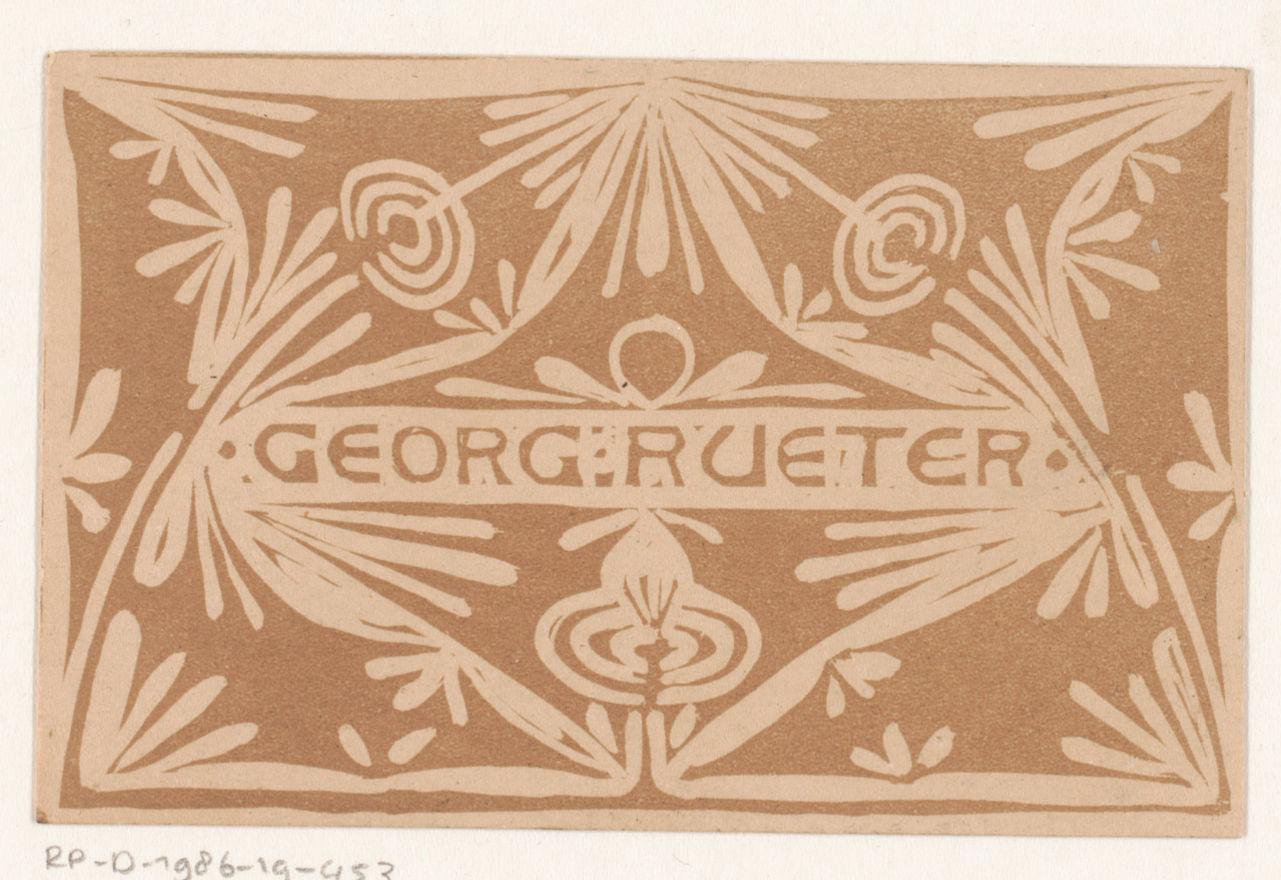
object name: visiting card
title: Visitekaartje van Georg Rueter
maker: georg rueter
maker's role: draughtsman, painter, print maker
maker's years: 1875-1966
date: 1898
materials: paper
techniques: woodcut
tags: haarlem, amsterdam, georg rueter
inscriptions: collector's mark: ‘R:MVS.’